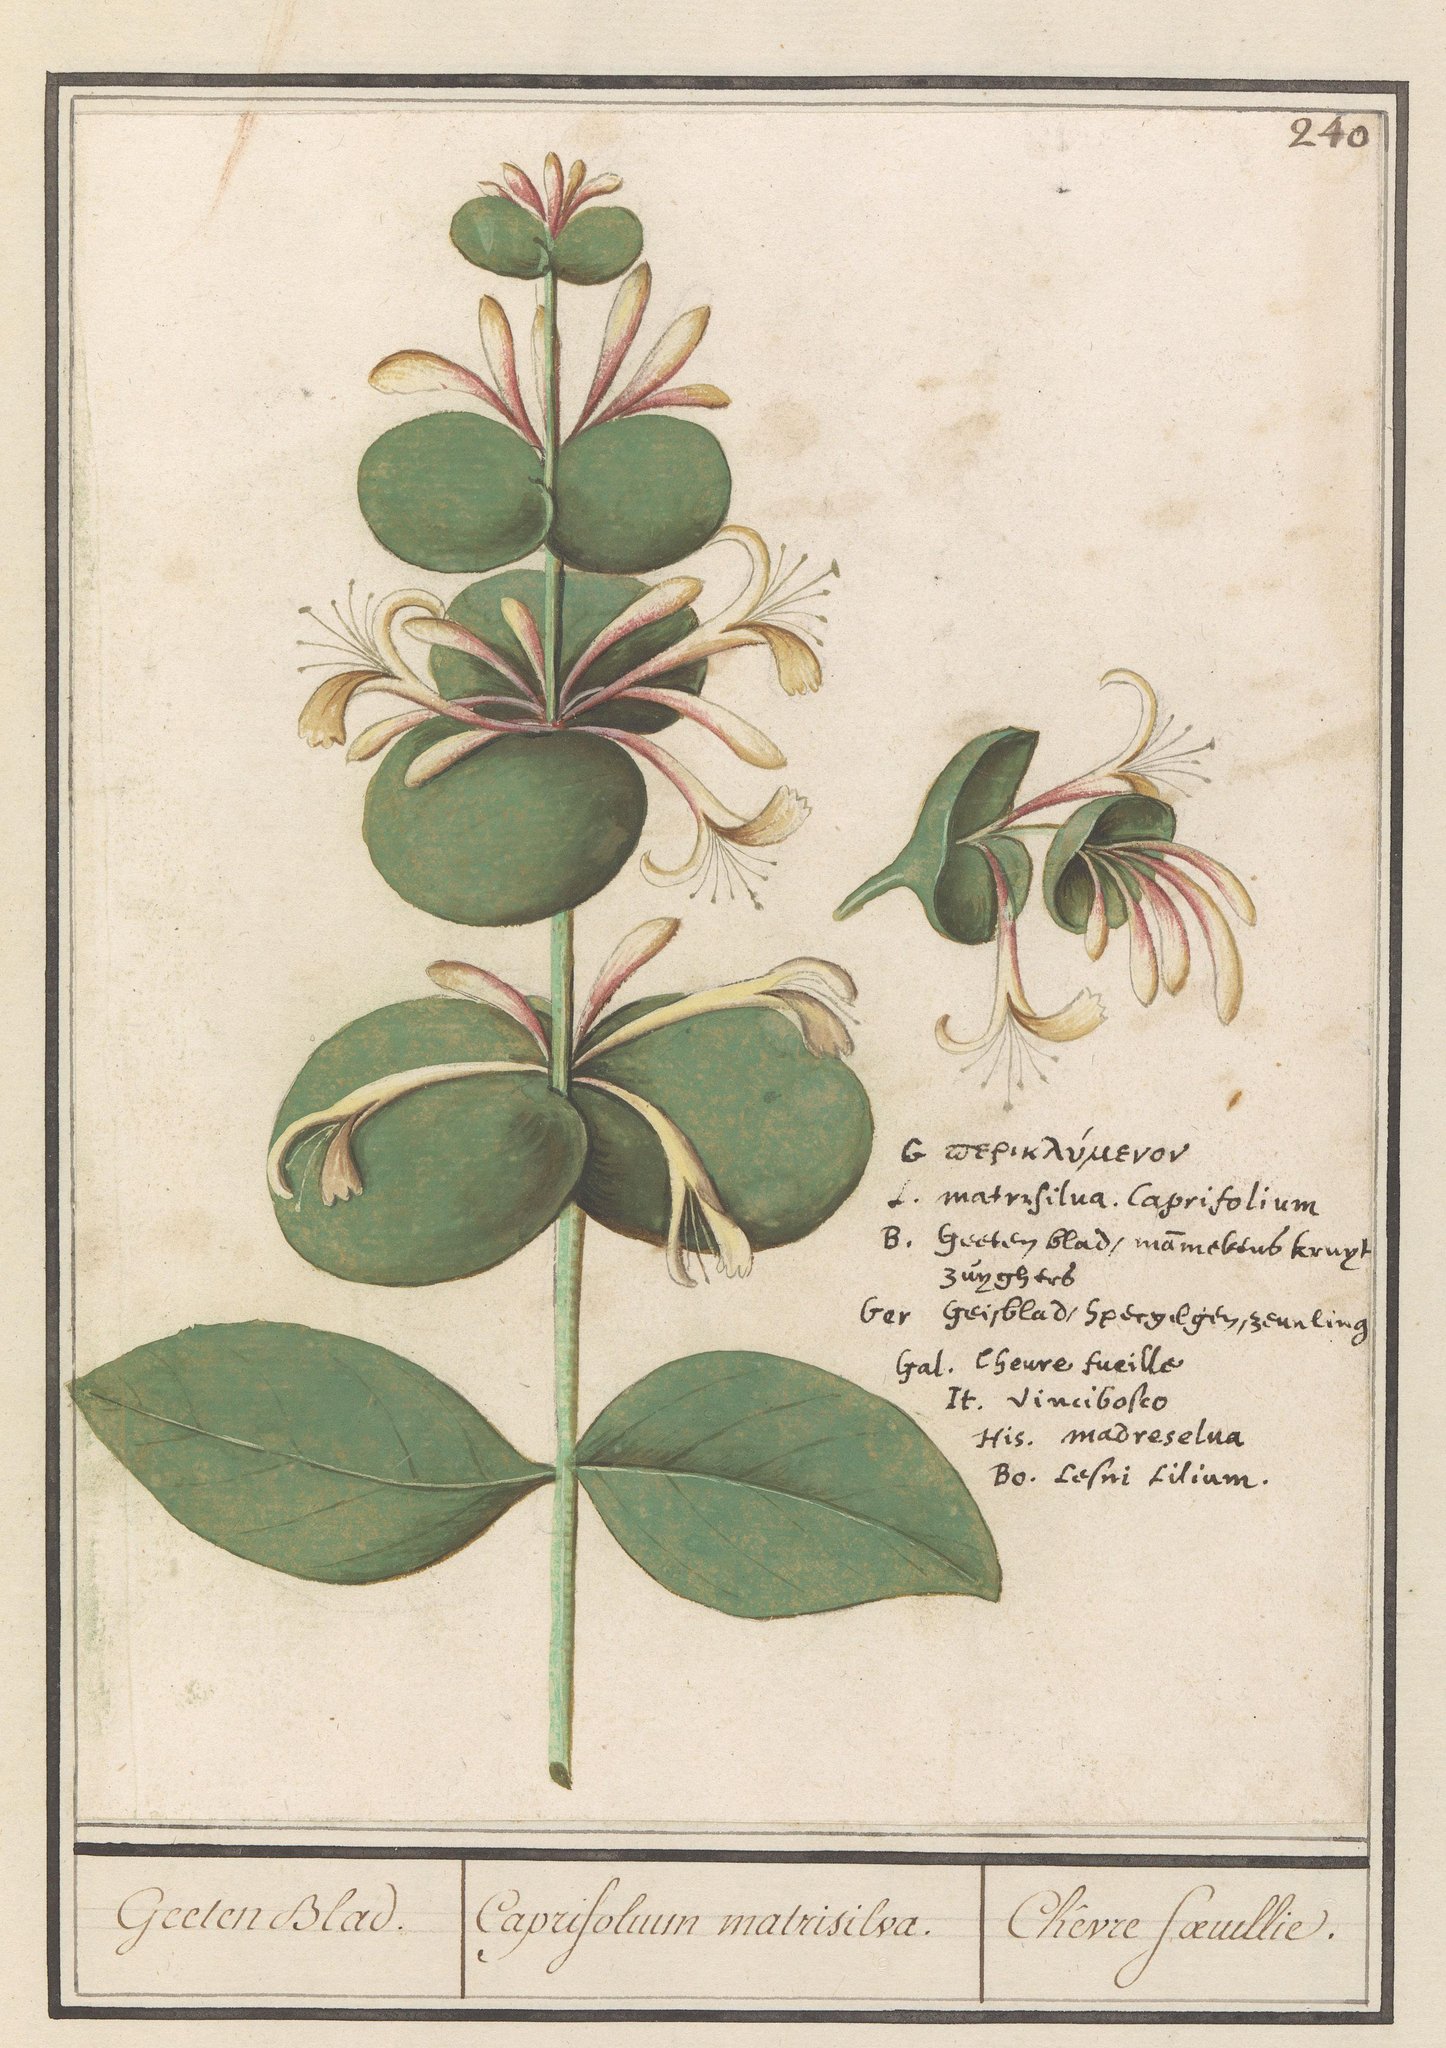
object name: drawing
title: Gewone kamperfoelie (Lonicera caprifolium)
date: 1596-1610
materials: chalk, paint, ink, paper, watercolor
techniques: brush, pen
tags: flowers: honeysuckle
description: Tuinkamperfoelie of gewone kamperfoelie. Genummerd rechtsboven: 240. Rechts de naam in acht talen. Onderdeel van het derde album met tekeningen van bloemen en planten. Tiende van twaalf albums met tekeningen van dieren, vogels en planten bekend rond 1600, gemaakt in opdracht van keizer Rudolf II. Met toelichting in Nederlands, Latijn en Frans.